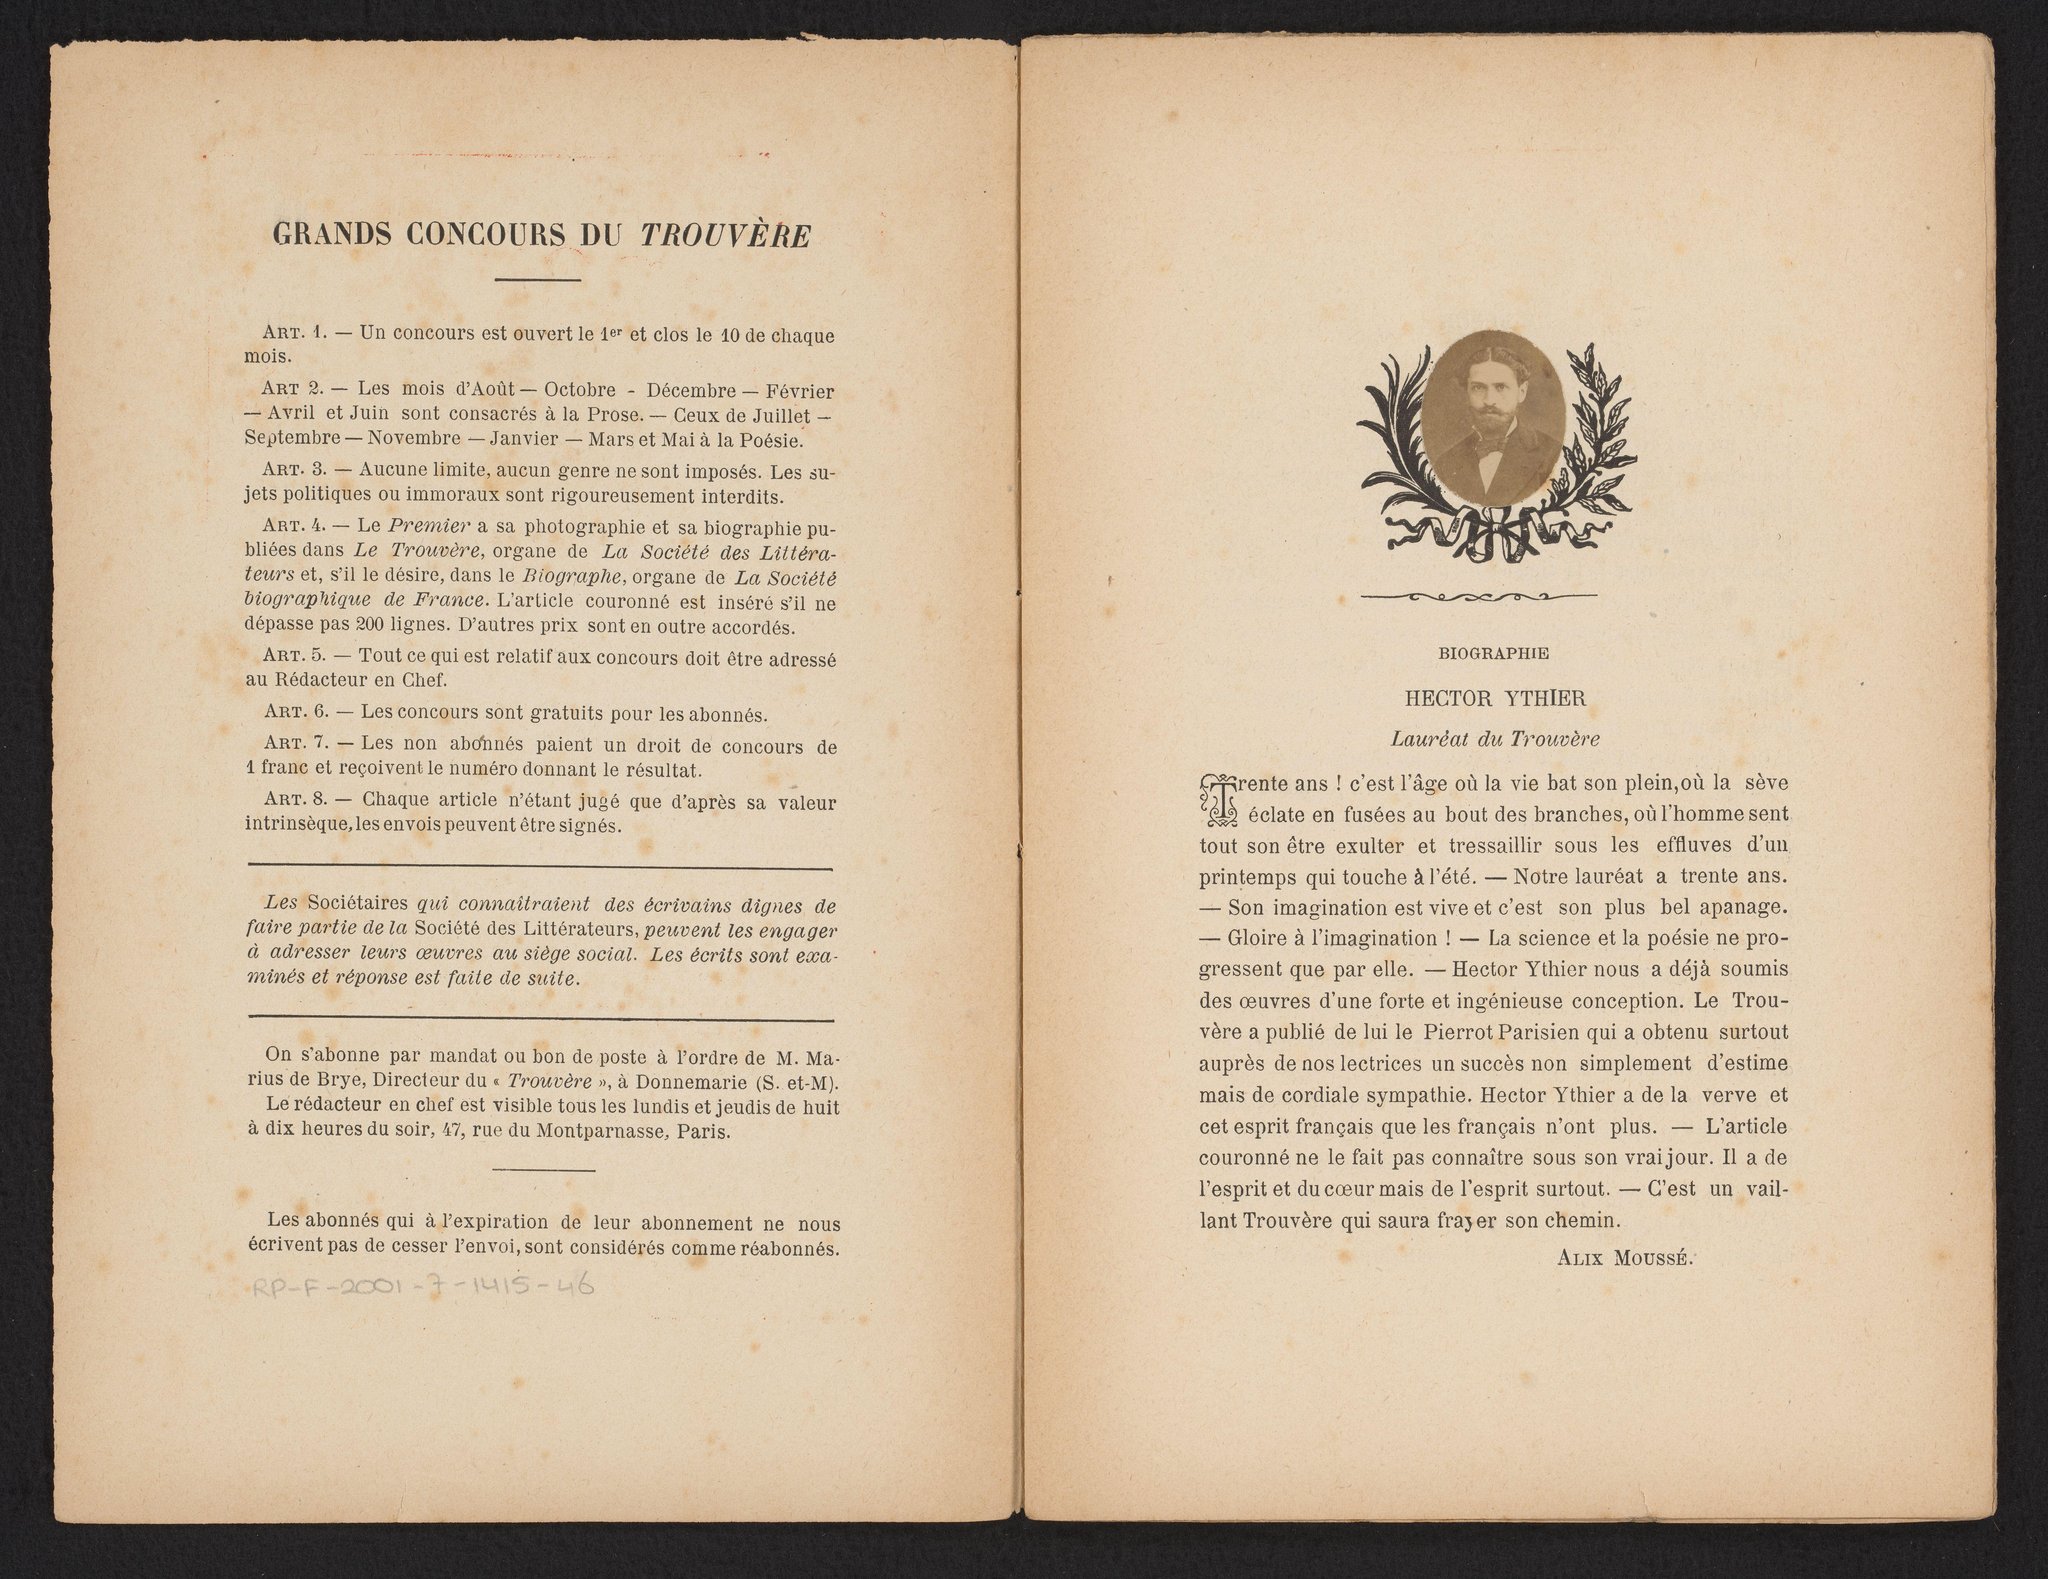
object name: photograph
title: Portret van Hector Ythier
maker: Anonymous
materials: photographic support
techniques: albumen print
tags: historical persons